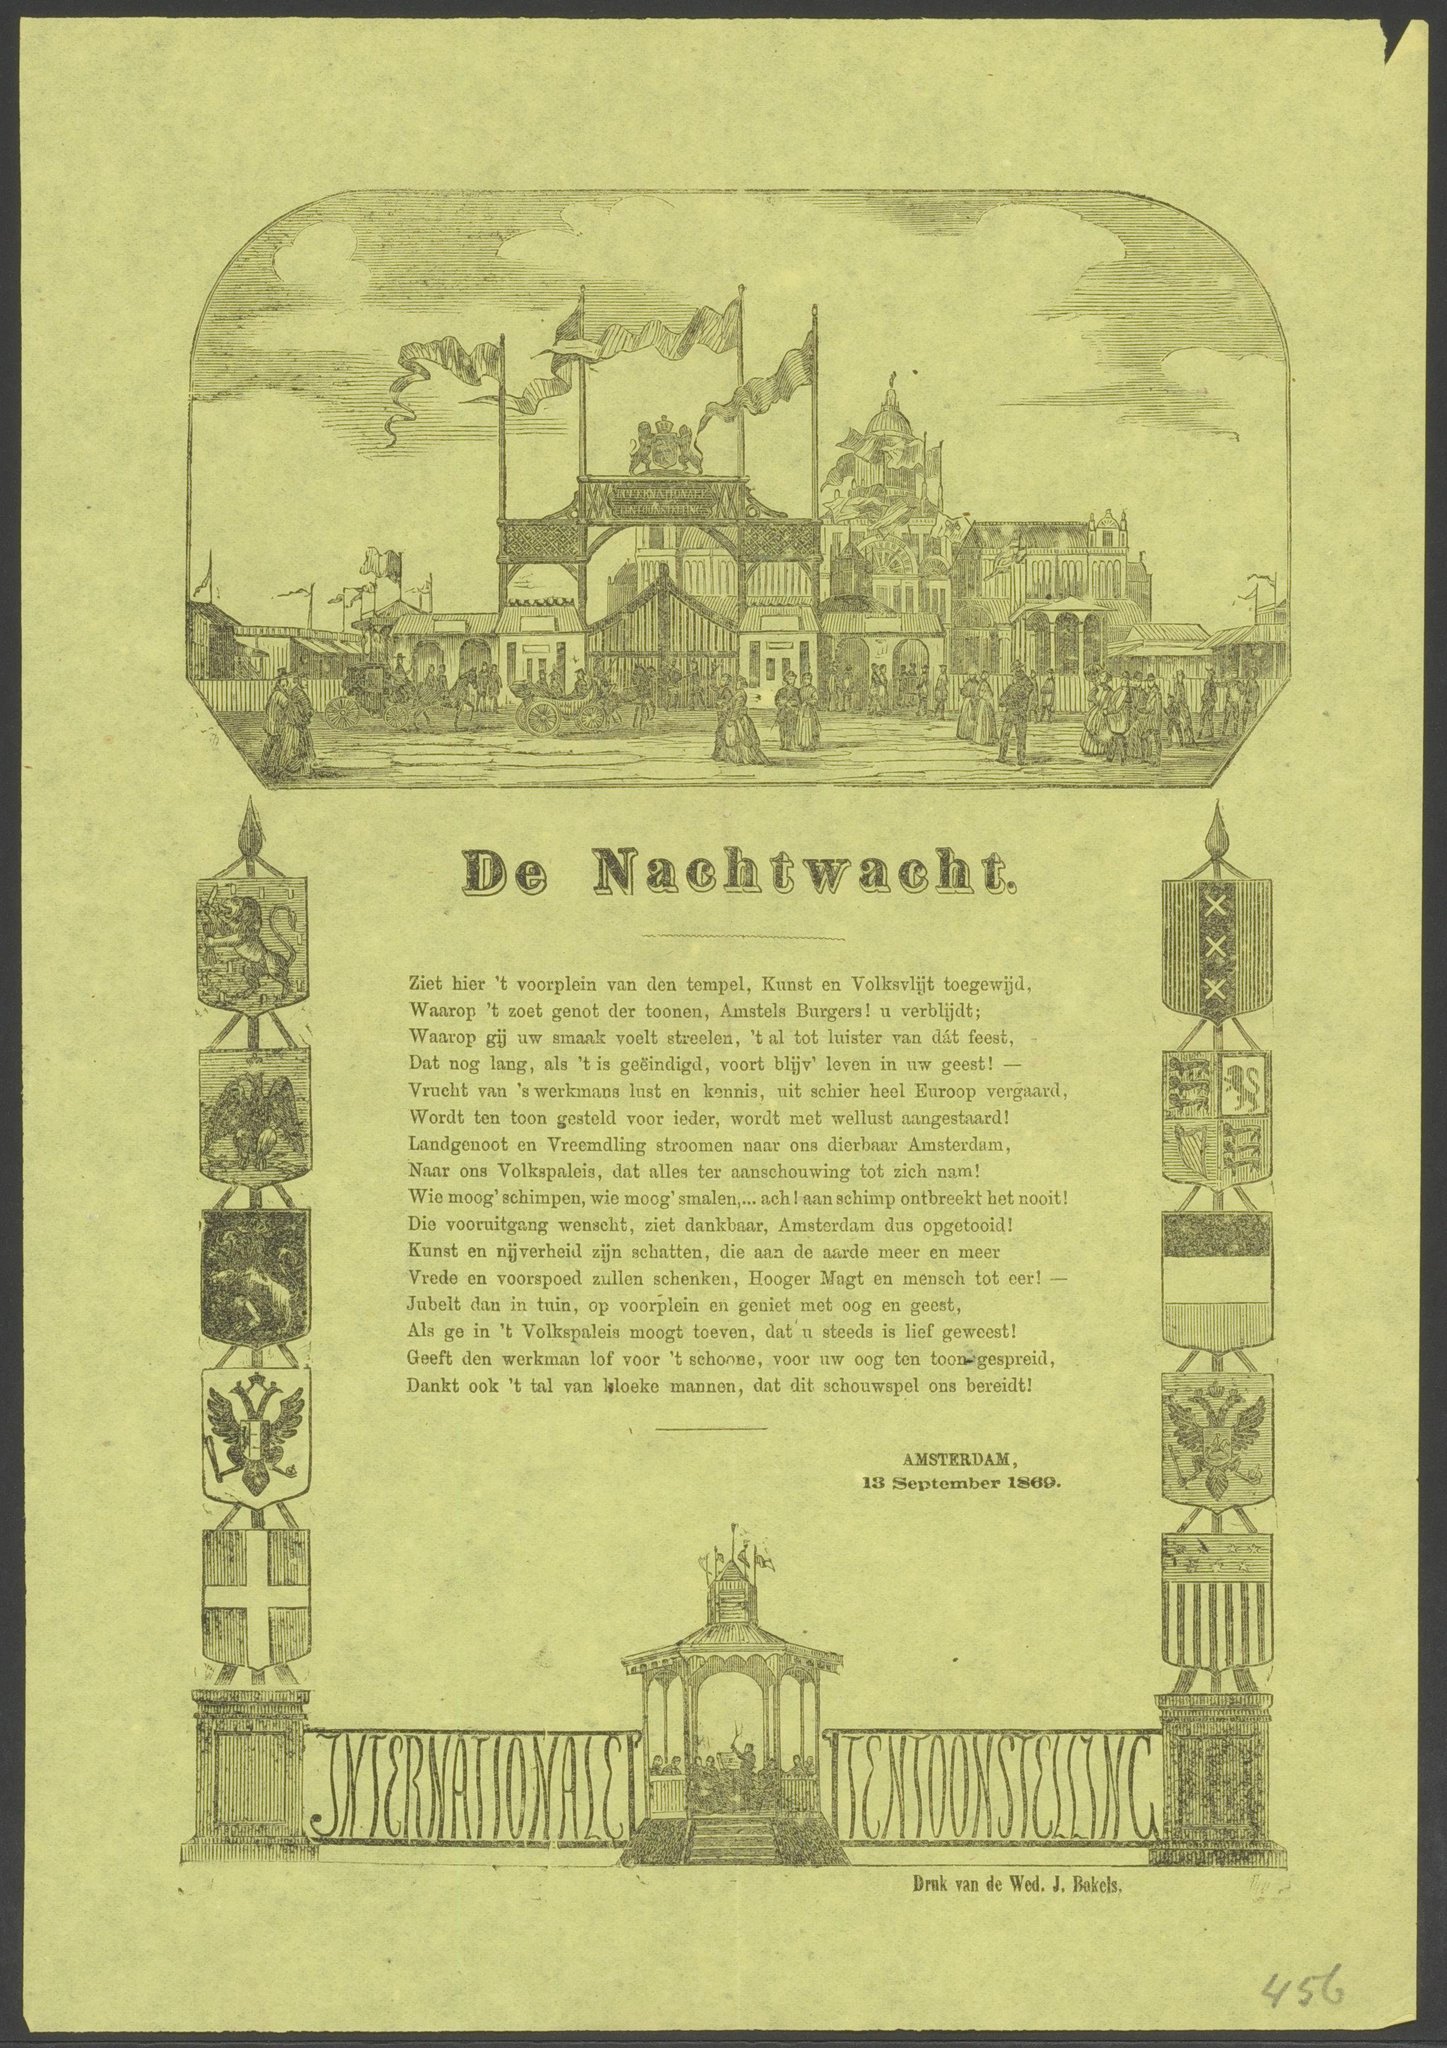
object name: fair print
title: De nachtwacht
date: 1869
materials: paper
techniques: letterpress printing, engraving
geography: amsterdam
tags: night patrol, pleasure fair and circus, amsterdam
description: Kermisprent van de Amsterdamse nachtwacht (ratelwacht), 13 september 1869. Onderwerpsrubrieken binnen de Atlas Zeden en Gewoonten: Zeden en gewoonten in engeren zin, Volksleven, Volksbladen, Nieuwjaars- en Kerstwenschen, Amsterdam.